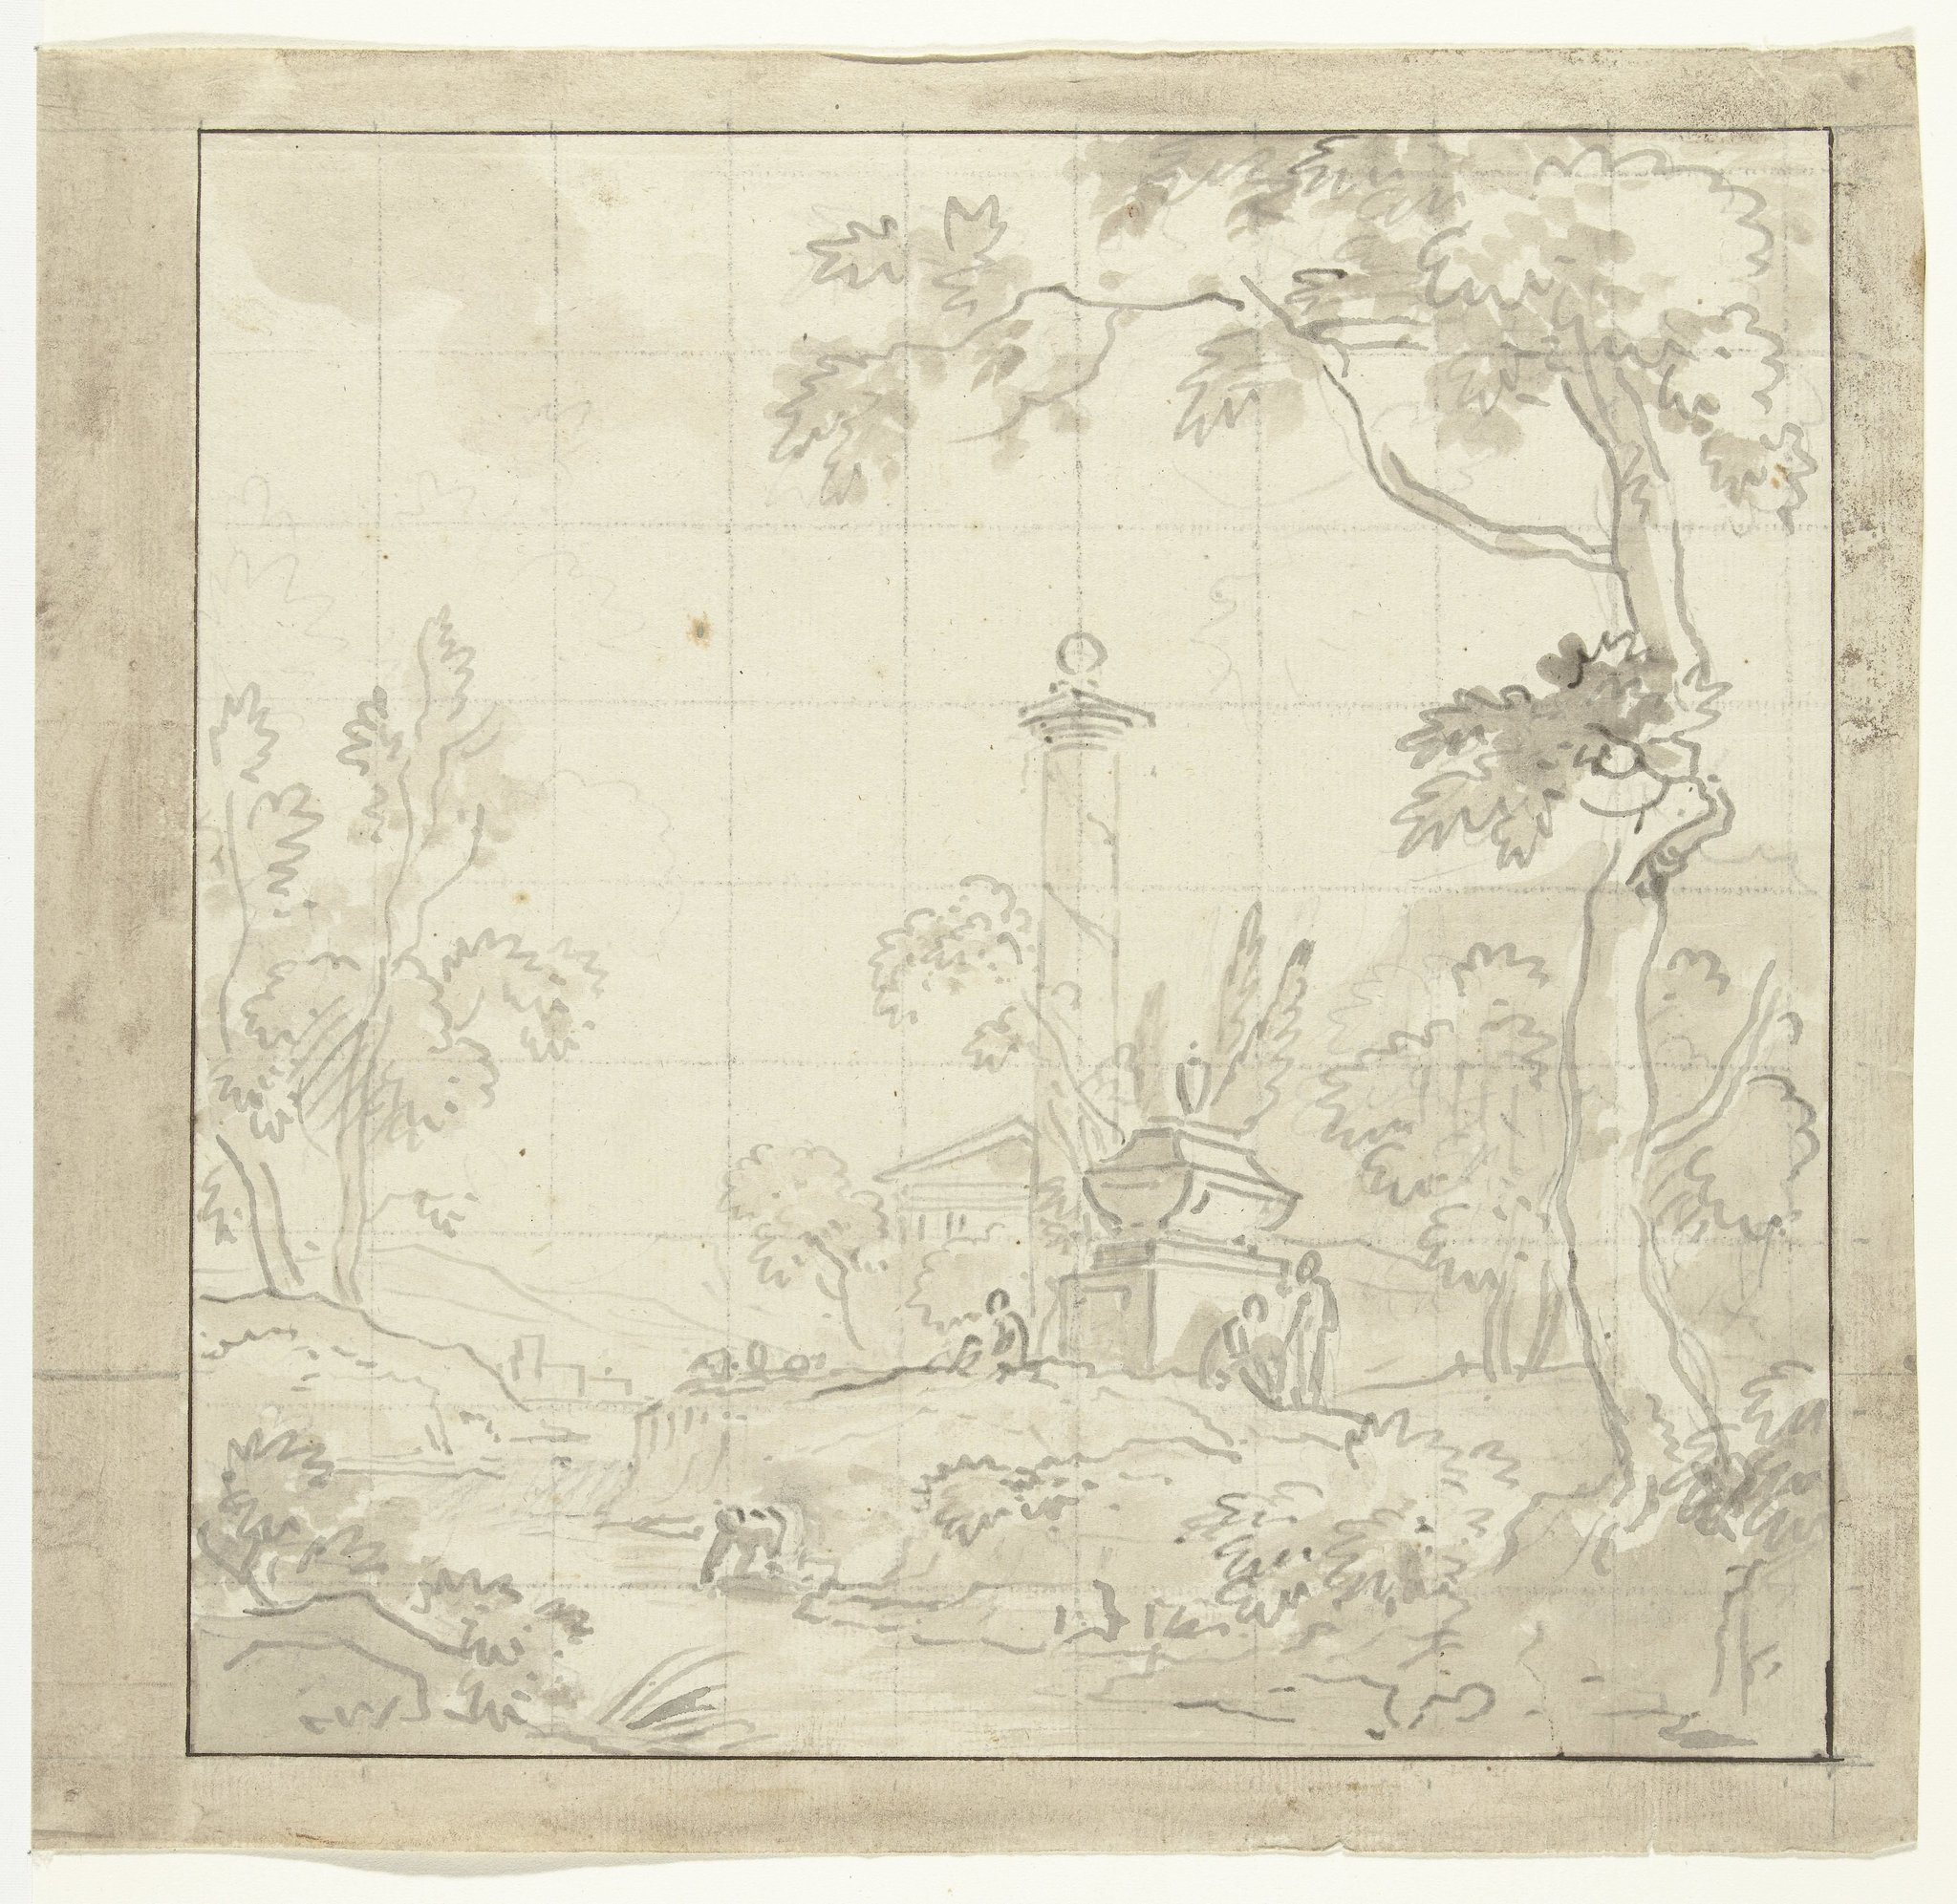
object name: drawing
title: Ontwerp voor behangselschildering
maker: jurriaan andriessen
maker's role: draughtsman, painter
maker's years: 1742-1819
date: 1752-1819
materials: chalk, graphite, ink, paper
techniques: brush, pen, drawing